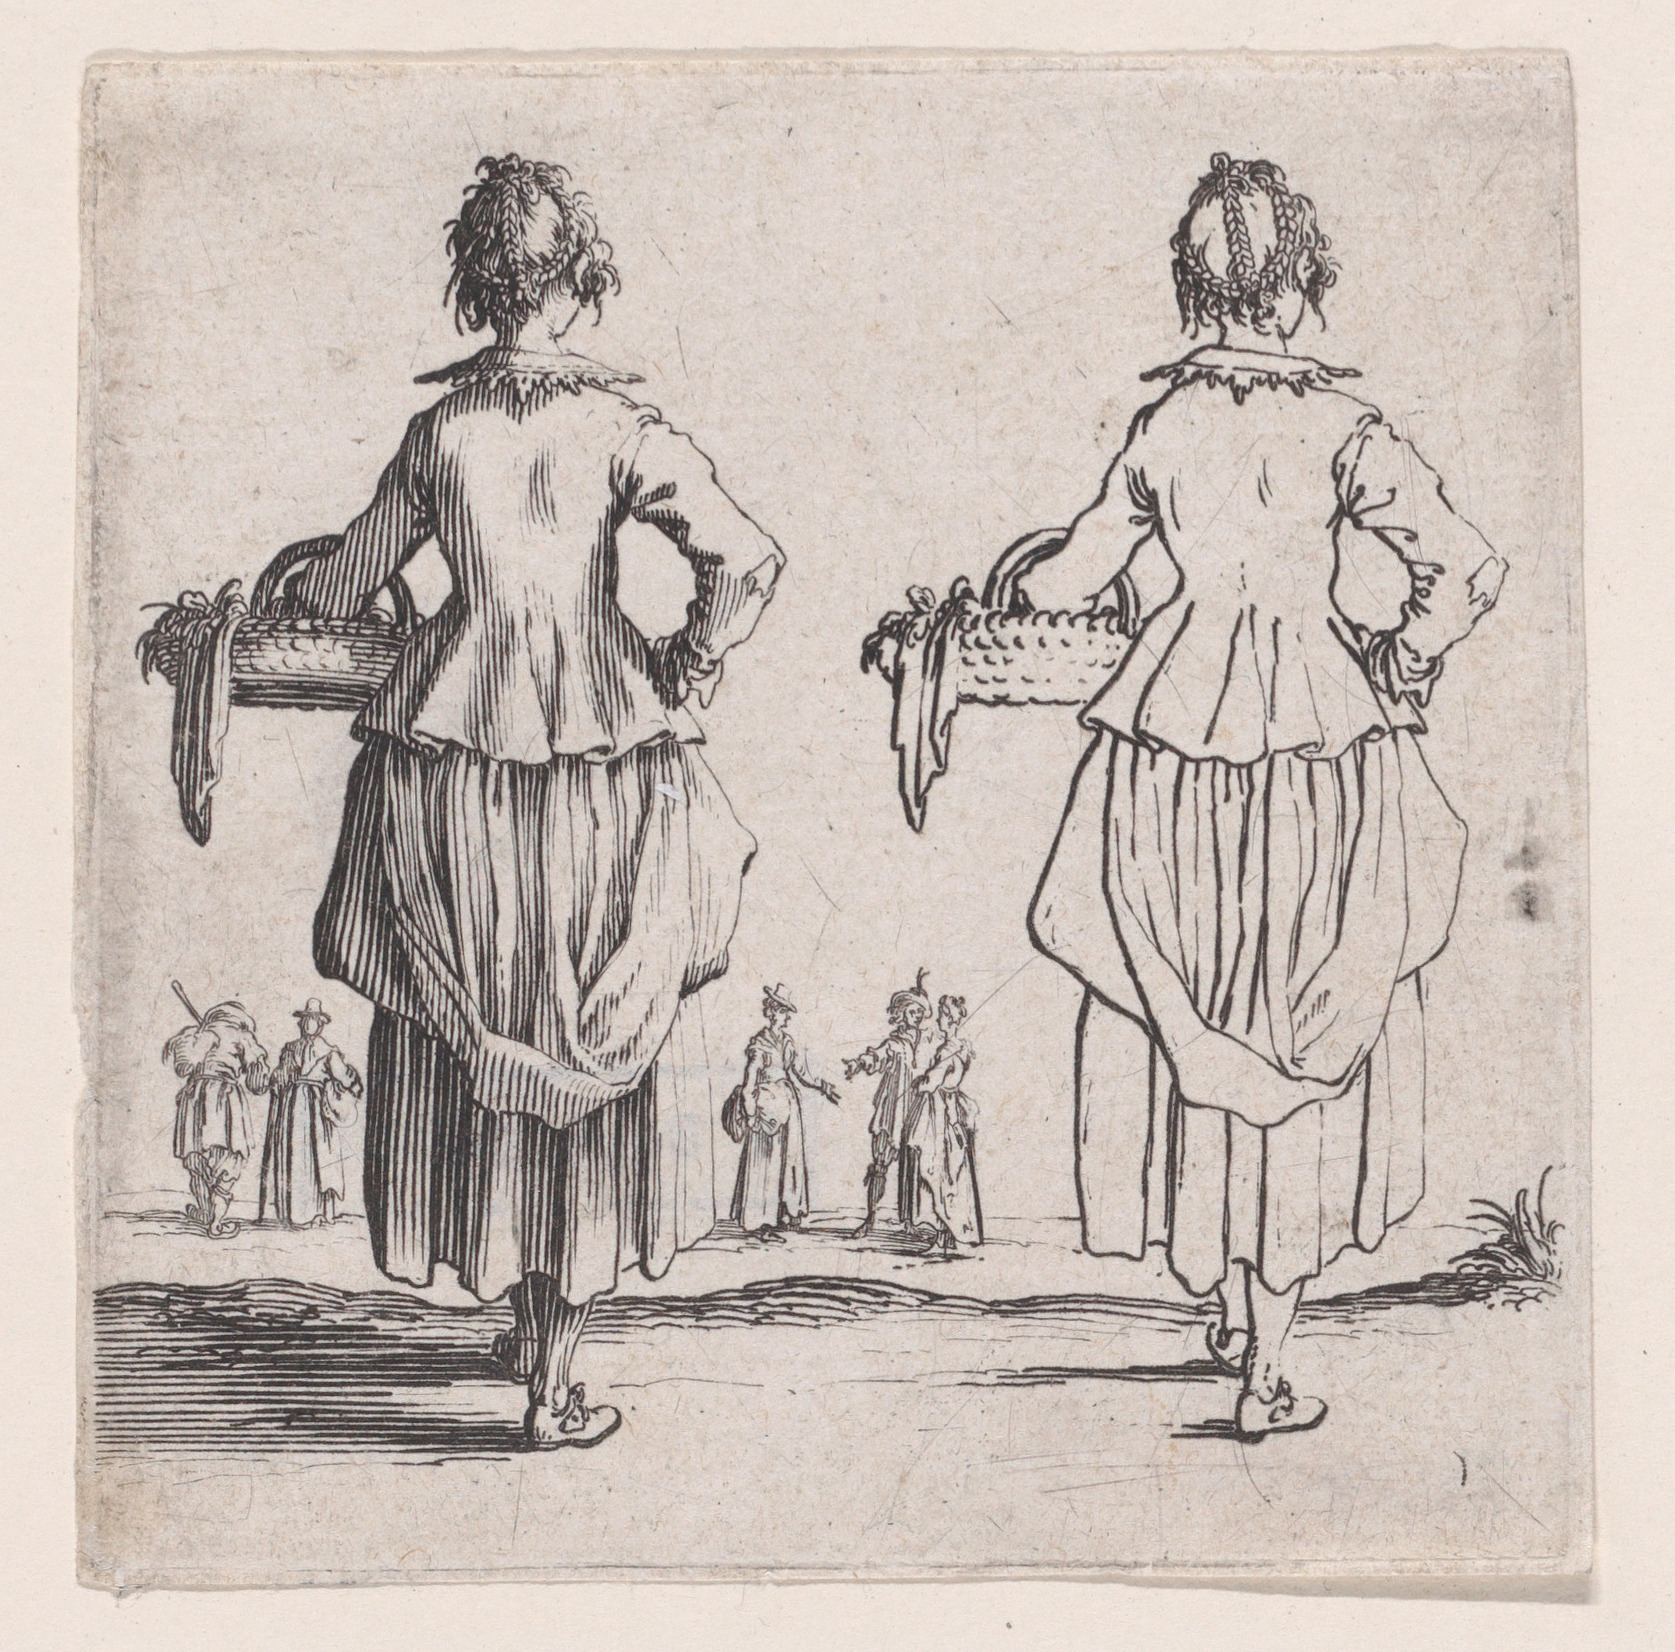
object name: print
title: La Paysanne Viewed de Dos, Tenant un Panier a son Bras Gauche (The Peasant Woman Viewed from Behind, Holding a Basket in his Left Arm), plate 1 from "Varie Figure" (Various Figures)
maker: jacques callot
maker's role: artist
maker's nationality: french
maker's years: 1592-1635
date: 1620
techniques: etching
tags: women,baskets